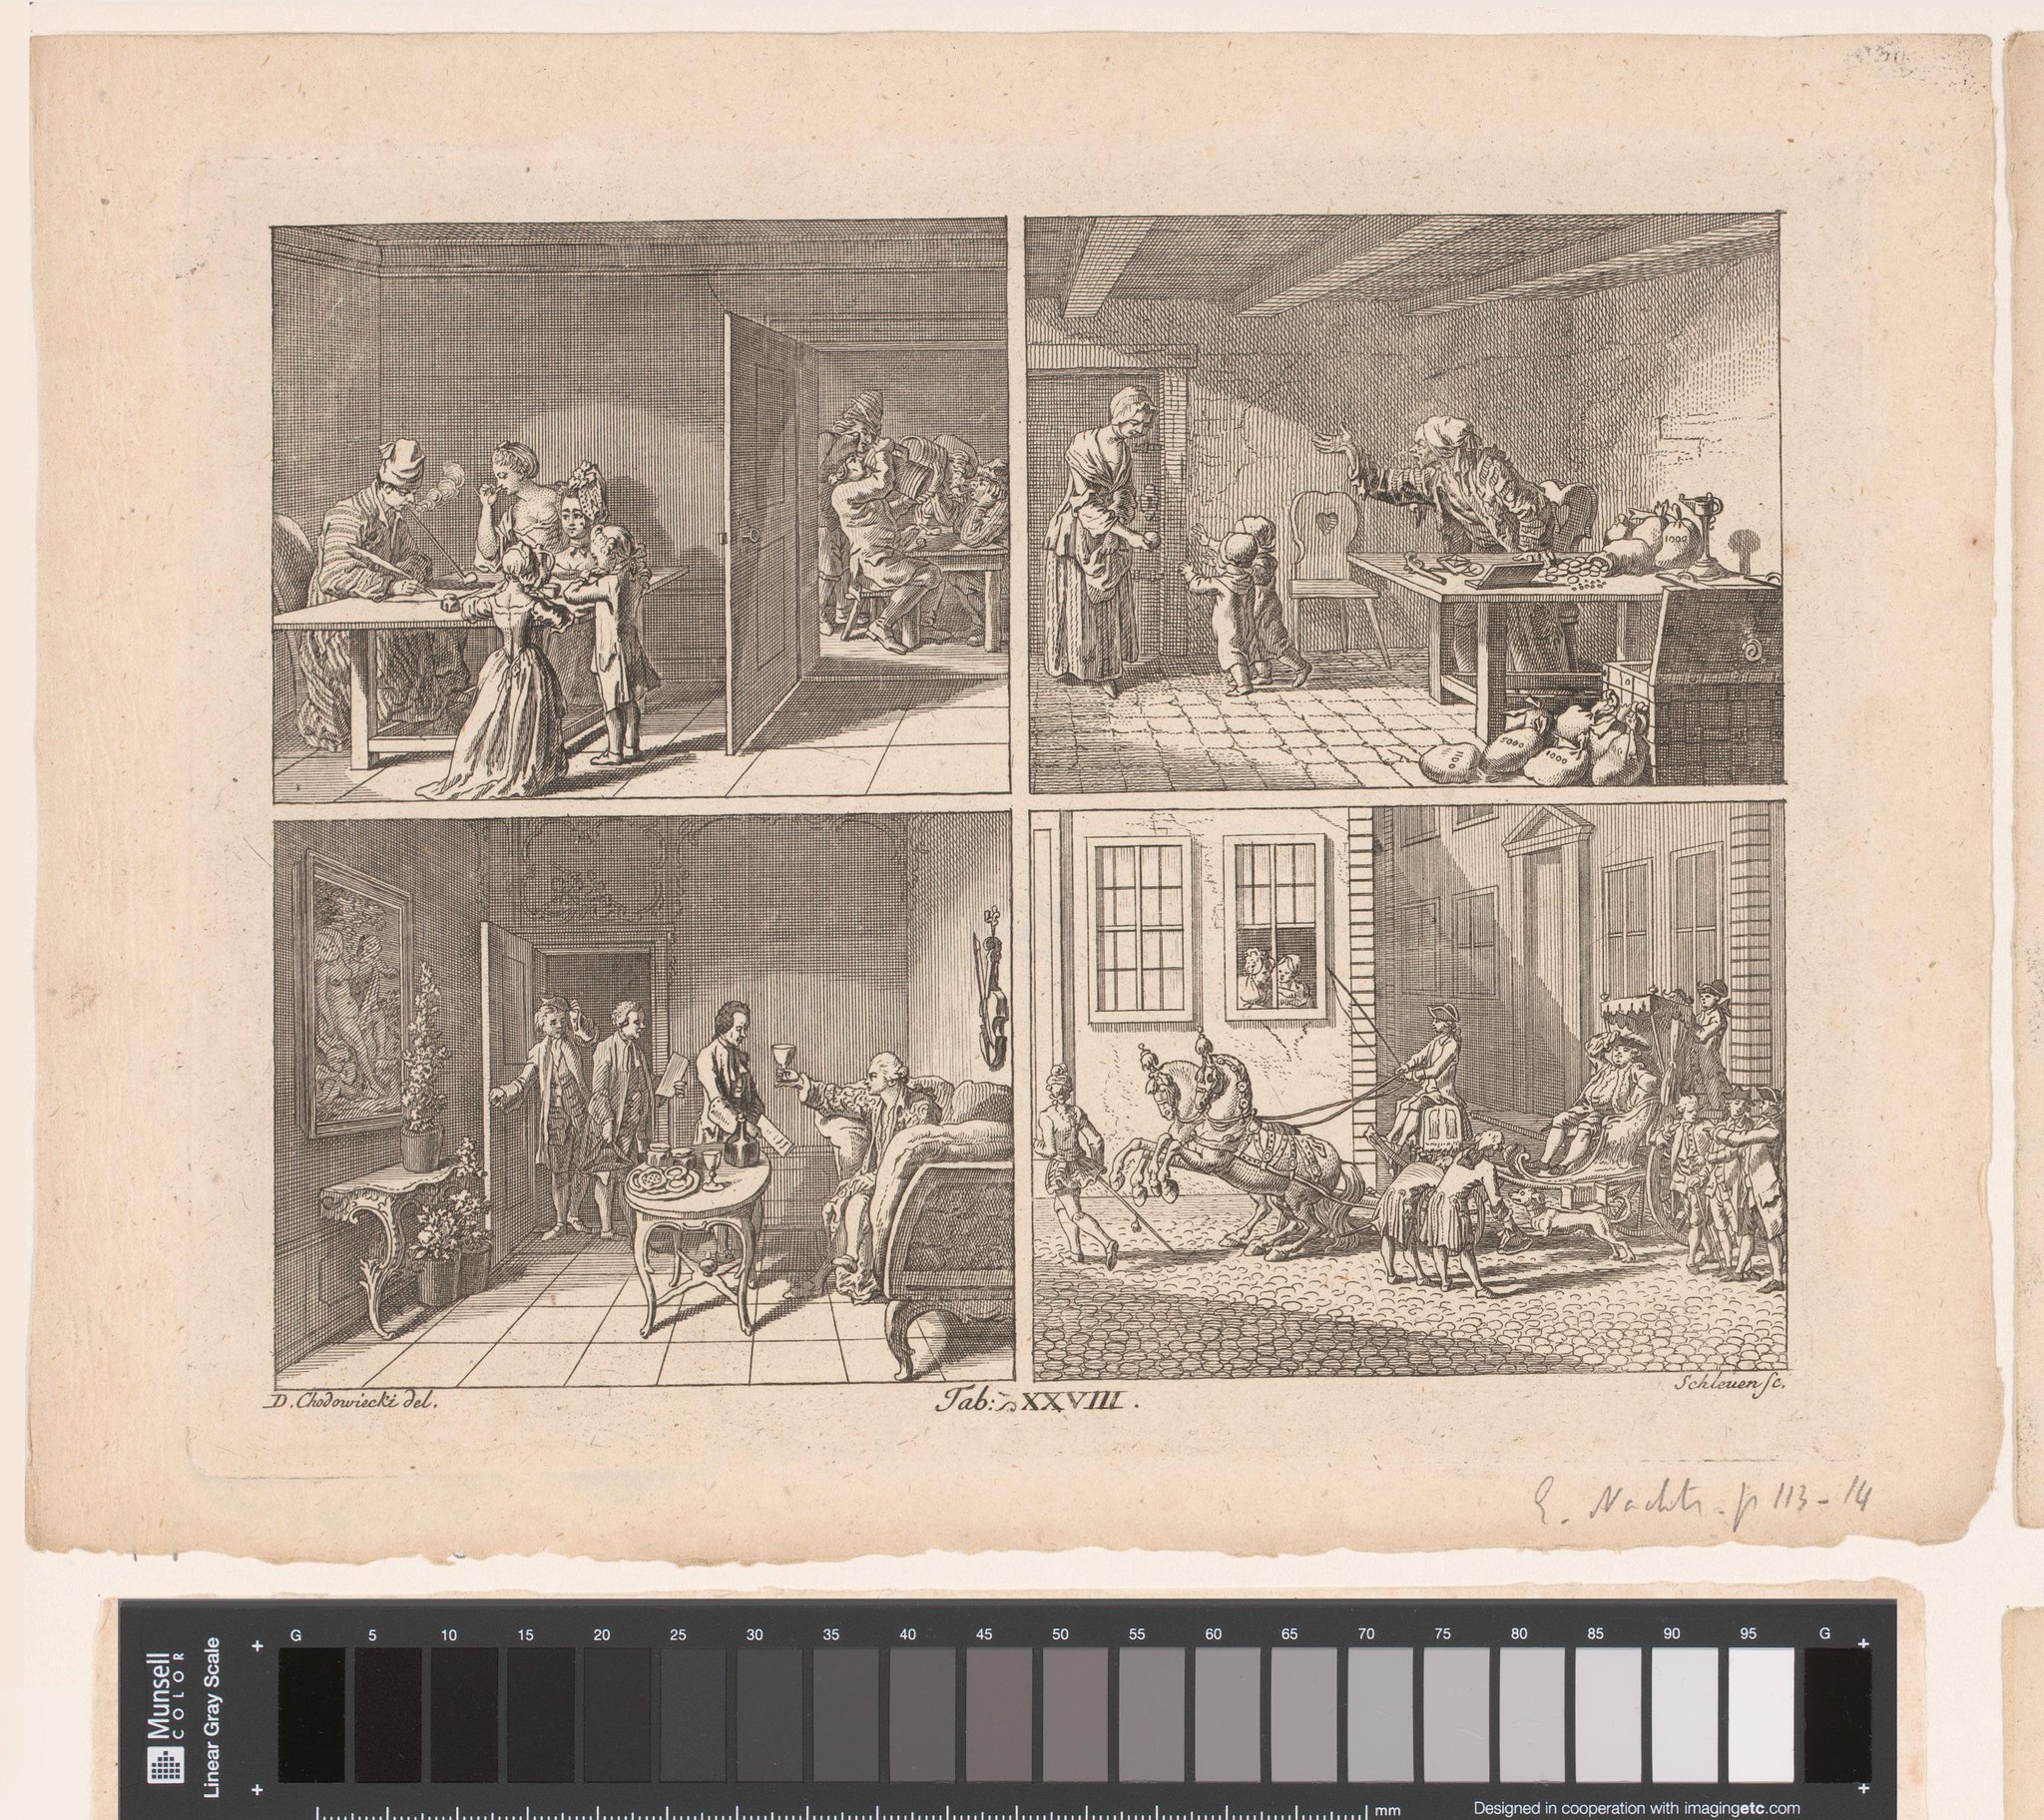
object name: print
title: Vier encyclopedische voorstellingen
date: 1765-1806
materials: paper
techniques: etching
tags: society, civilization, culture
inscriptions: collector's mark: Lugt 2228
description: Prent ook gebruikt in: Allgemeine deutsche Bibliothek. Berlijn en Stettin: Friedrich Nicolai, 1765-1806.